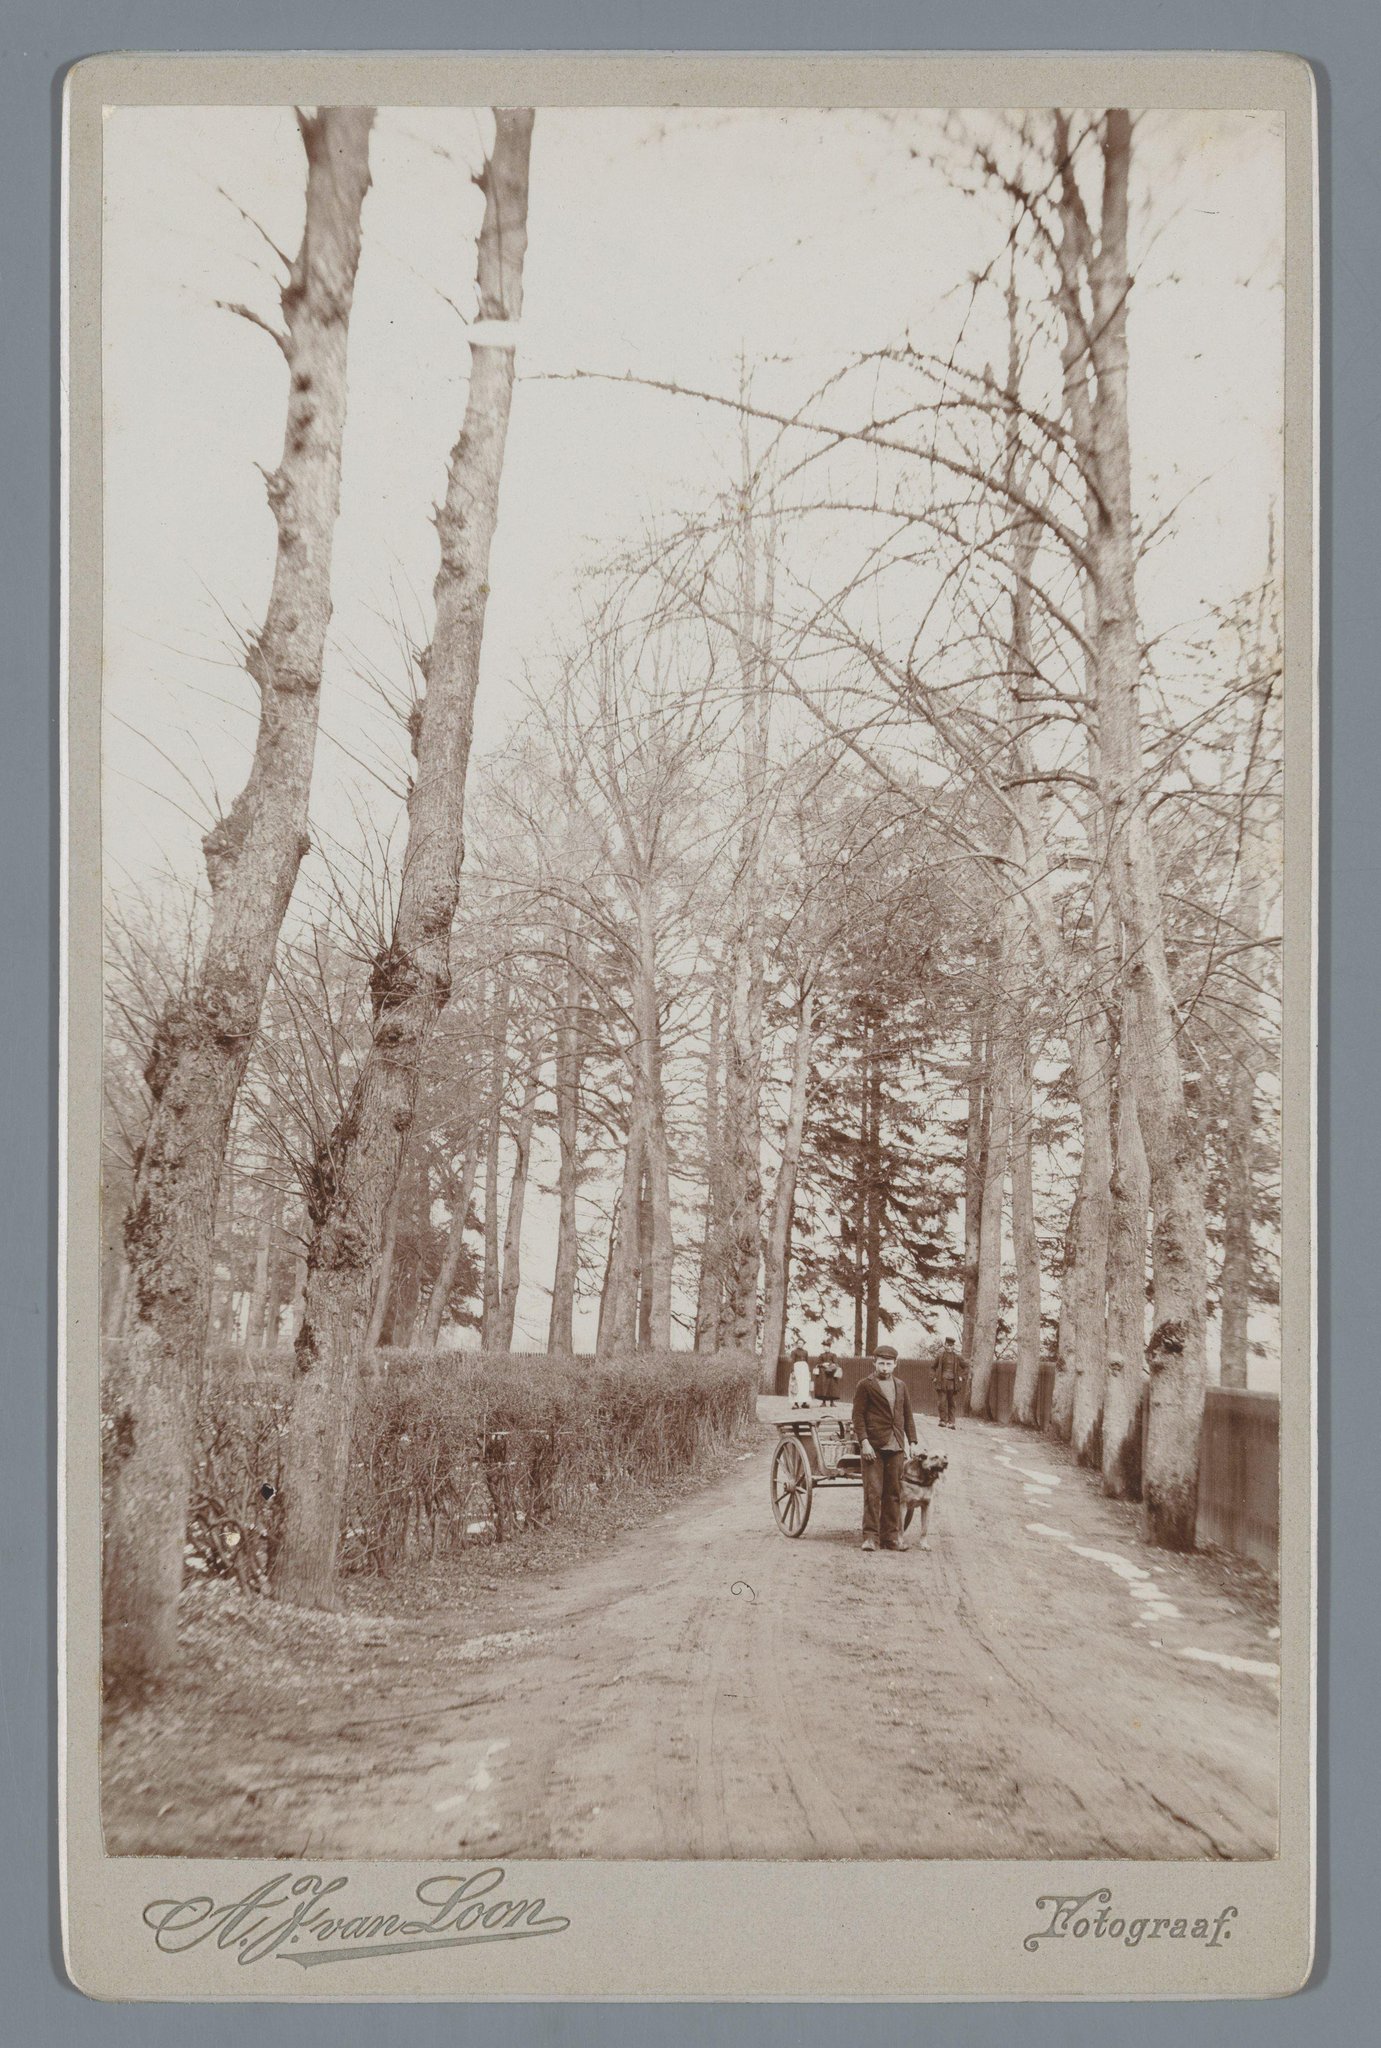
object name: photograph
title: Portret van een man met hond in de omgeving van de Grebbe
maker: a.j. van loon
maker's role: fotograaf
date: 1880-1940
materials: paper, cardboard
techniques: collodion silver print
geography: veenendaal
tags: garden approach, garden drive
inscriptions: inscription: ‘Gezicht nabij "De Grebbe"’